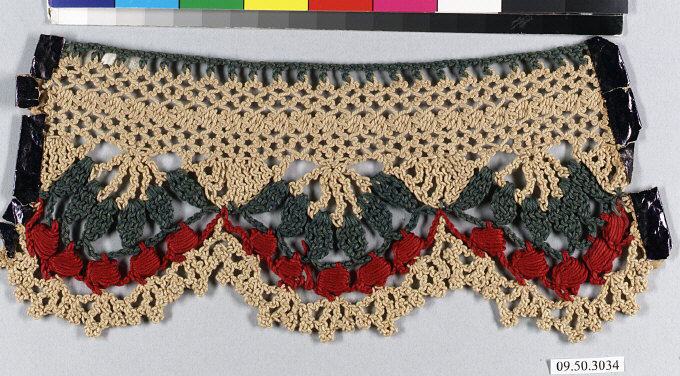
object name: sample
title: Crochet Work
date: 1801-1900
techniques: crochet